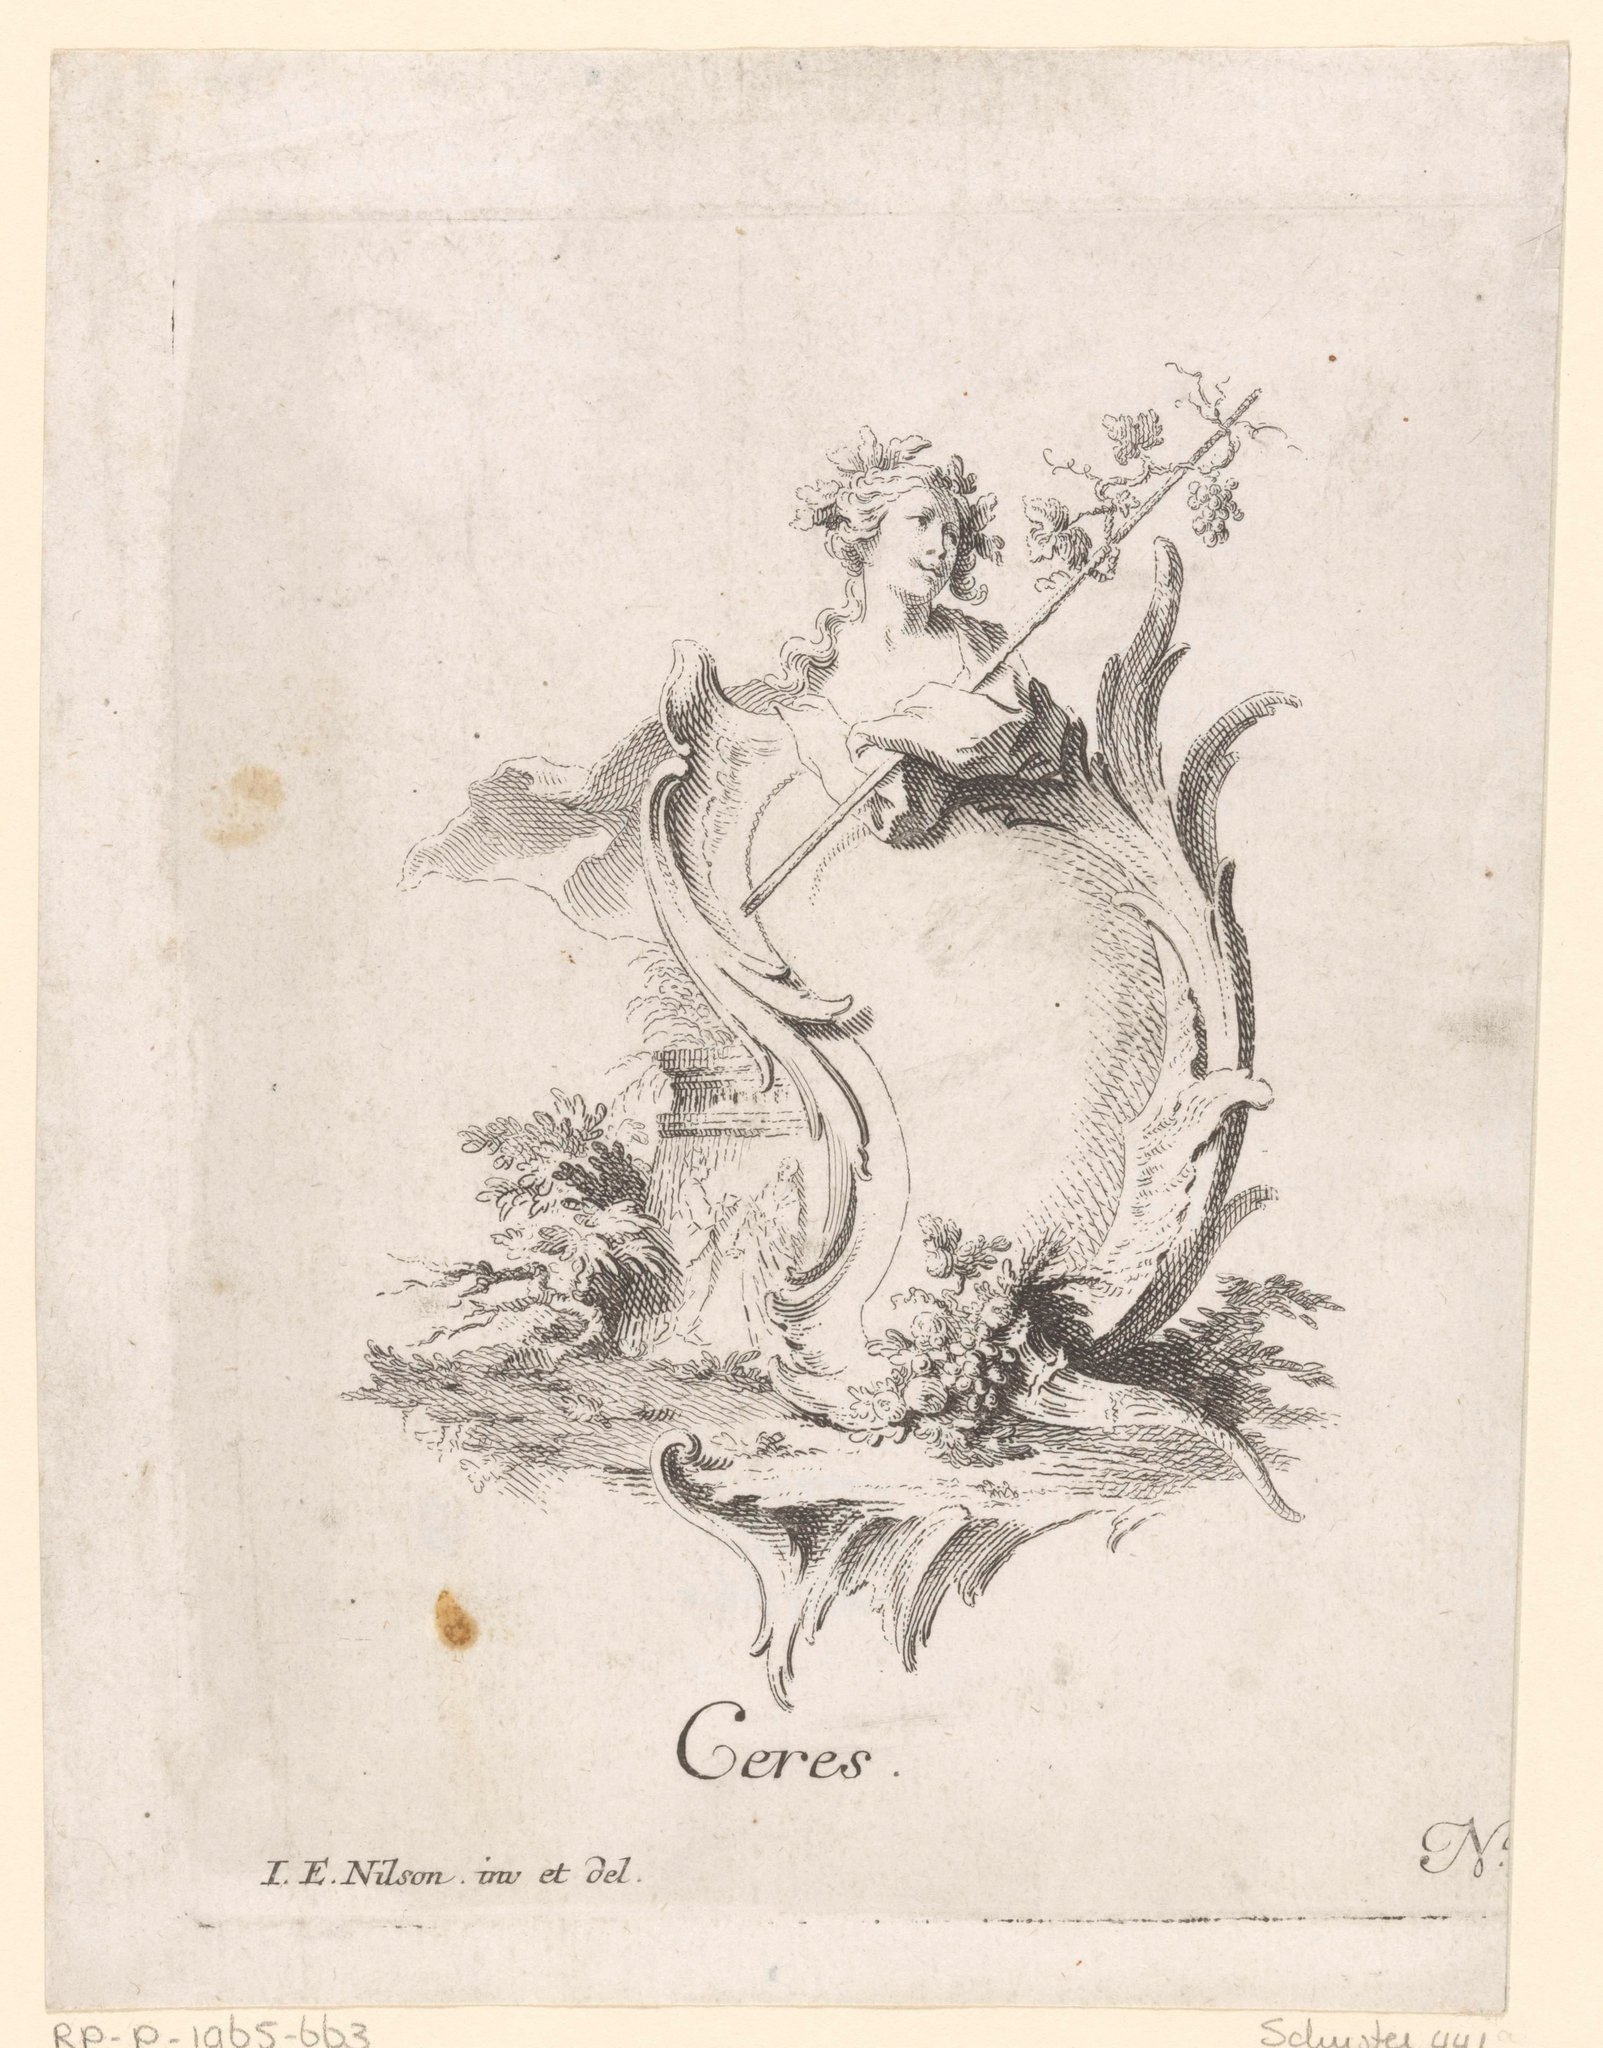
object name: print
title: Ceres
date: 1731-1775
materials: paper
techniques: engraving, etching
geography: augsburg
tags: specific aspects, allegorical aspects of ceres; ceres as patroness, ornament ~ cartouche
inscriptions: collector's mark: Lugt 2760, collector's mark: Lugt 2228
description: Cartouche met buste van de godin Ceres met druivenranken en de hoorn des overvloeds. Uitgeversnummer 52.